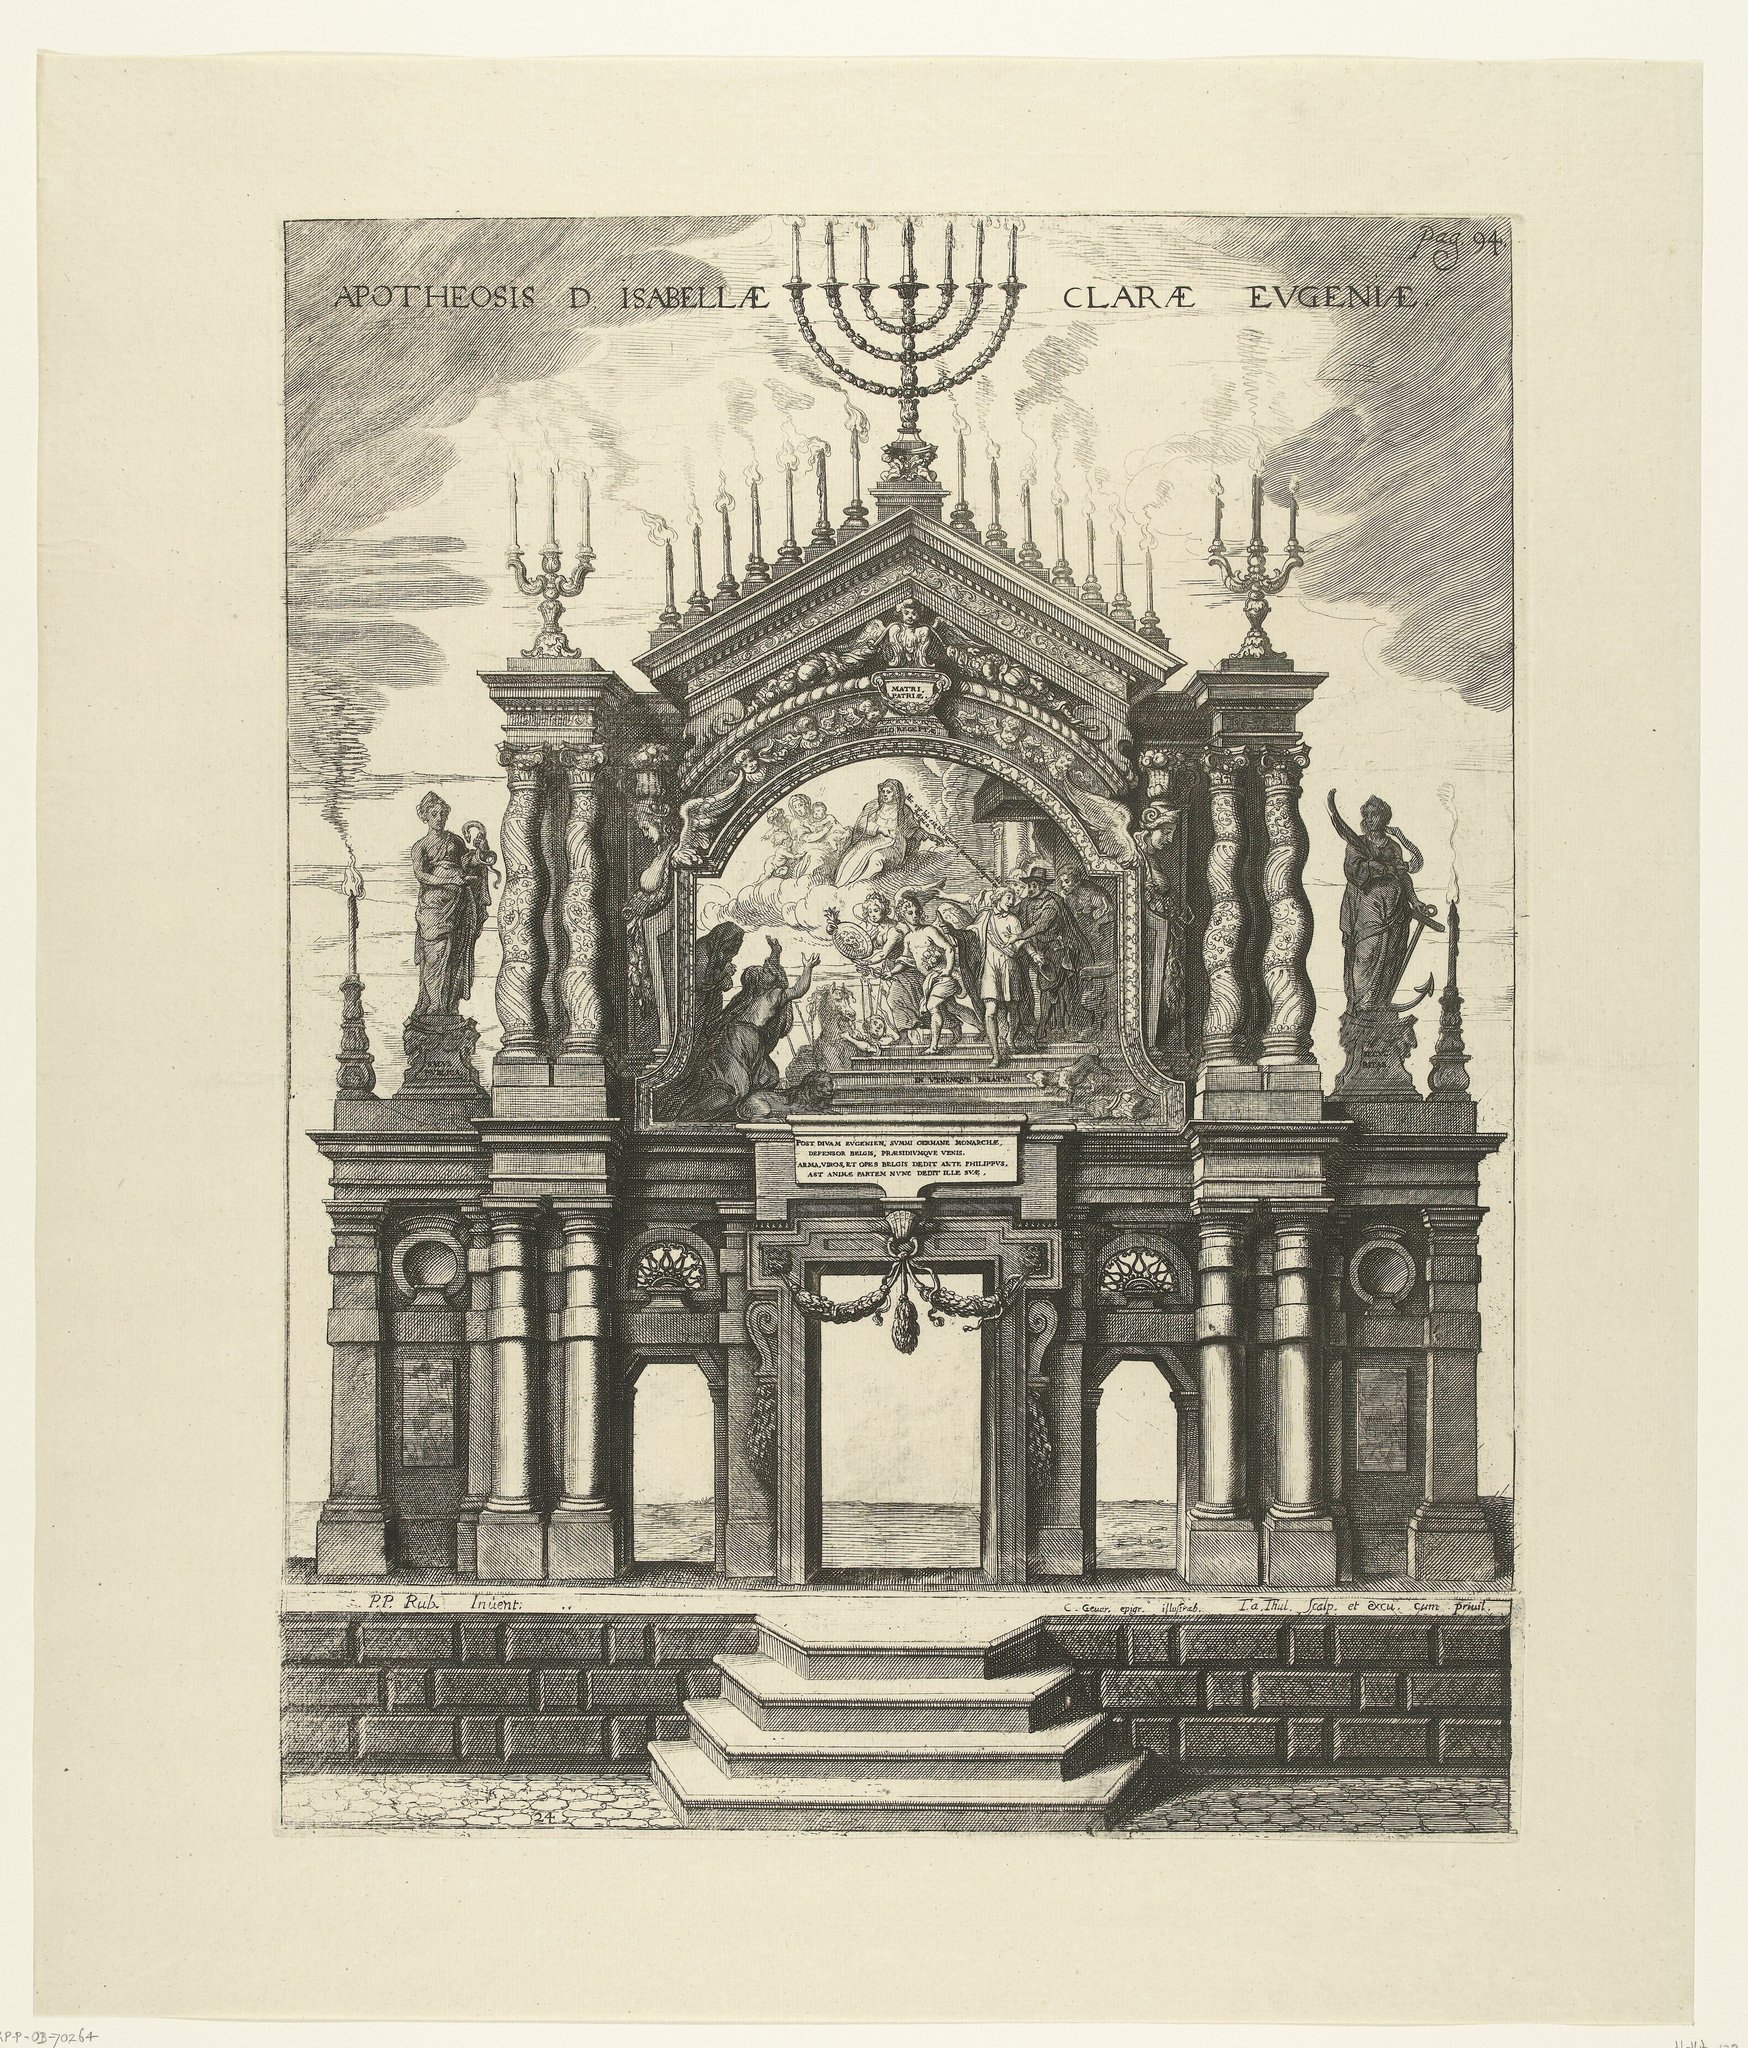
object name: print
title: Apotheosis D. Isabellae Clarae Eugeniae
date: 1639-1641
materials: paper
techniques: engraving, etching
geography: southern netherlands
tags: filips iv (koning van spanje), infante van spanje isabella clara eugenia, landvoogd der zuidelijke nederlanden ferdinand van oostenrijk, triumphal arch, antwerp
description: De triomfboog van Isabella Clara Eugenia opgesteld in de Clarenstraat. Centraal een voorstelling van de aanstelling van Ferdinand als gouverneur over de Nederlanden door Filips IV. Bovenop een zevenarmige kandelaar en zeven kaarsen aan weerszijden. Gemerkt rechtsboven: pag. 94. Blad nr. 24 in een geheel van 43 platen die de uitgave van de beschrijving van de intocht van de Kardinaal Infant Ferdinand van Oostenrijk te Antwerpen op 17 april 1635 als de nieuwe landvoogd voor de Spaanse Nederlanden illustreren.